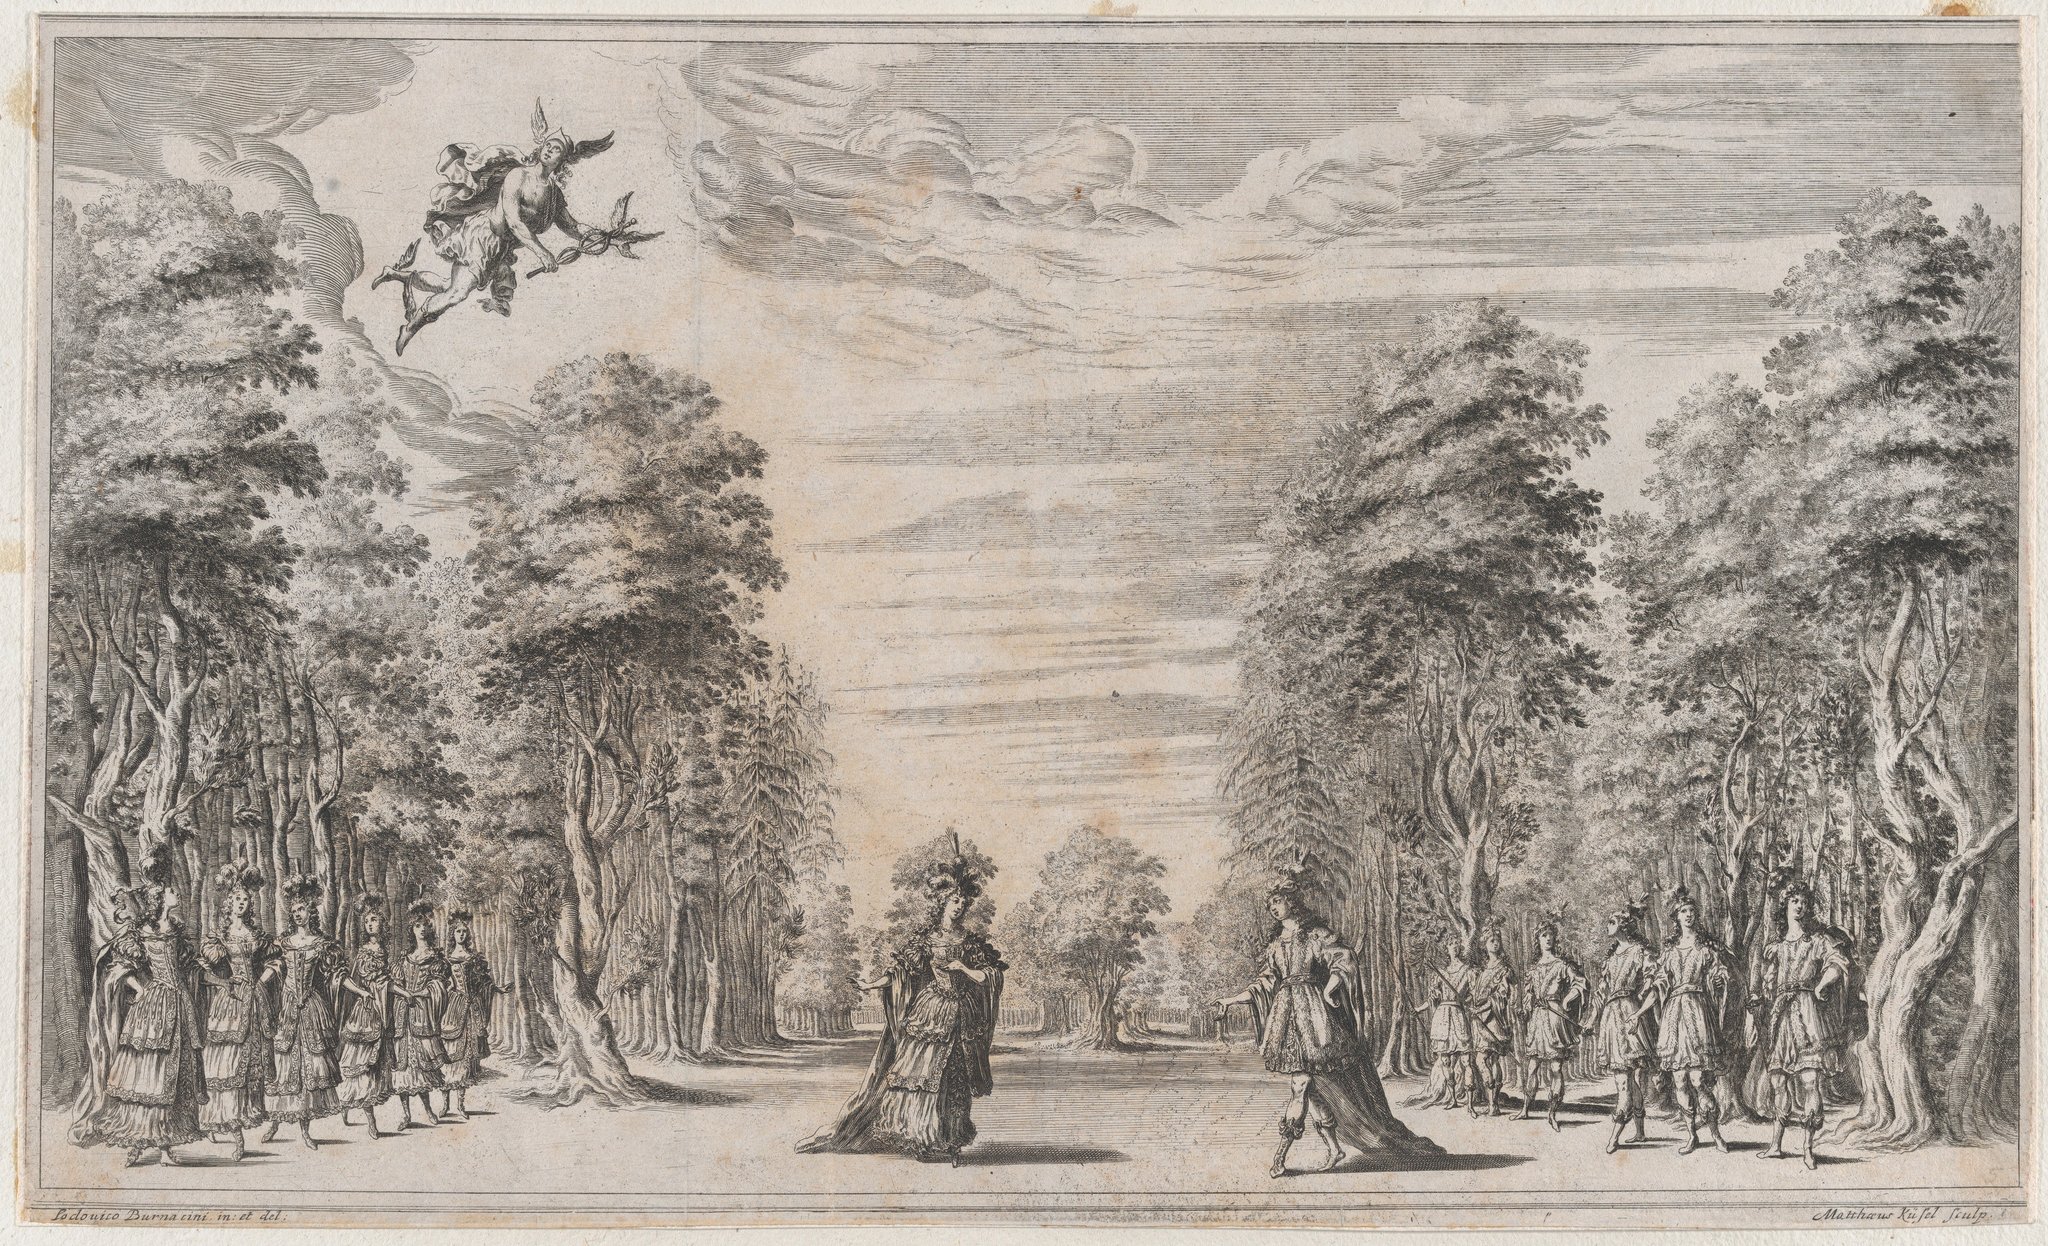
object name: print, fete, ornament architecture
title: A man and a woman conversing at center, surrounded by a row of young men to the right and young women to the left, Mercury appears at top left corner; set design from 'Il Pomo D'Oro'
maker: mathäus küsel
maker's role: artist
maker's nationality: german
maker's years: 1621-1682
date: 1668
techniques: engraving, etching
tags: men,women,mercury,trees